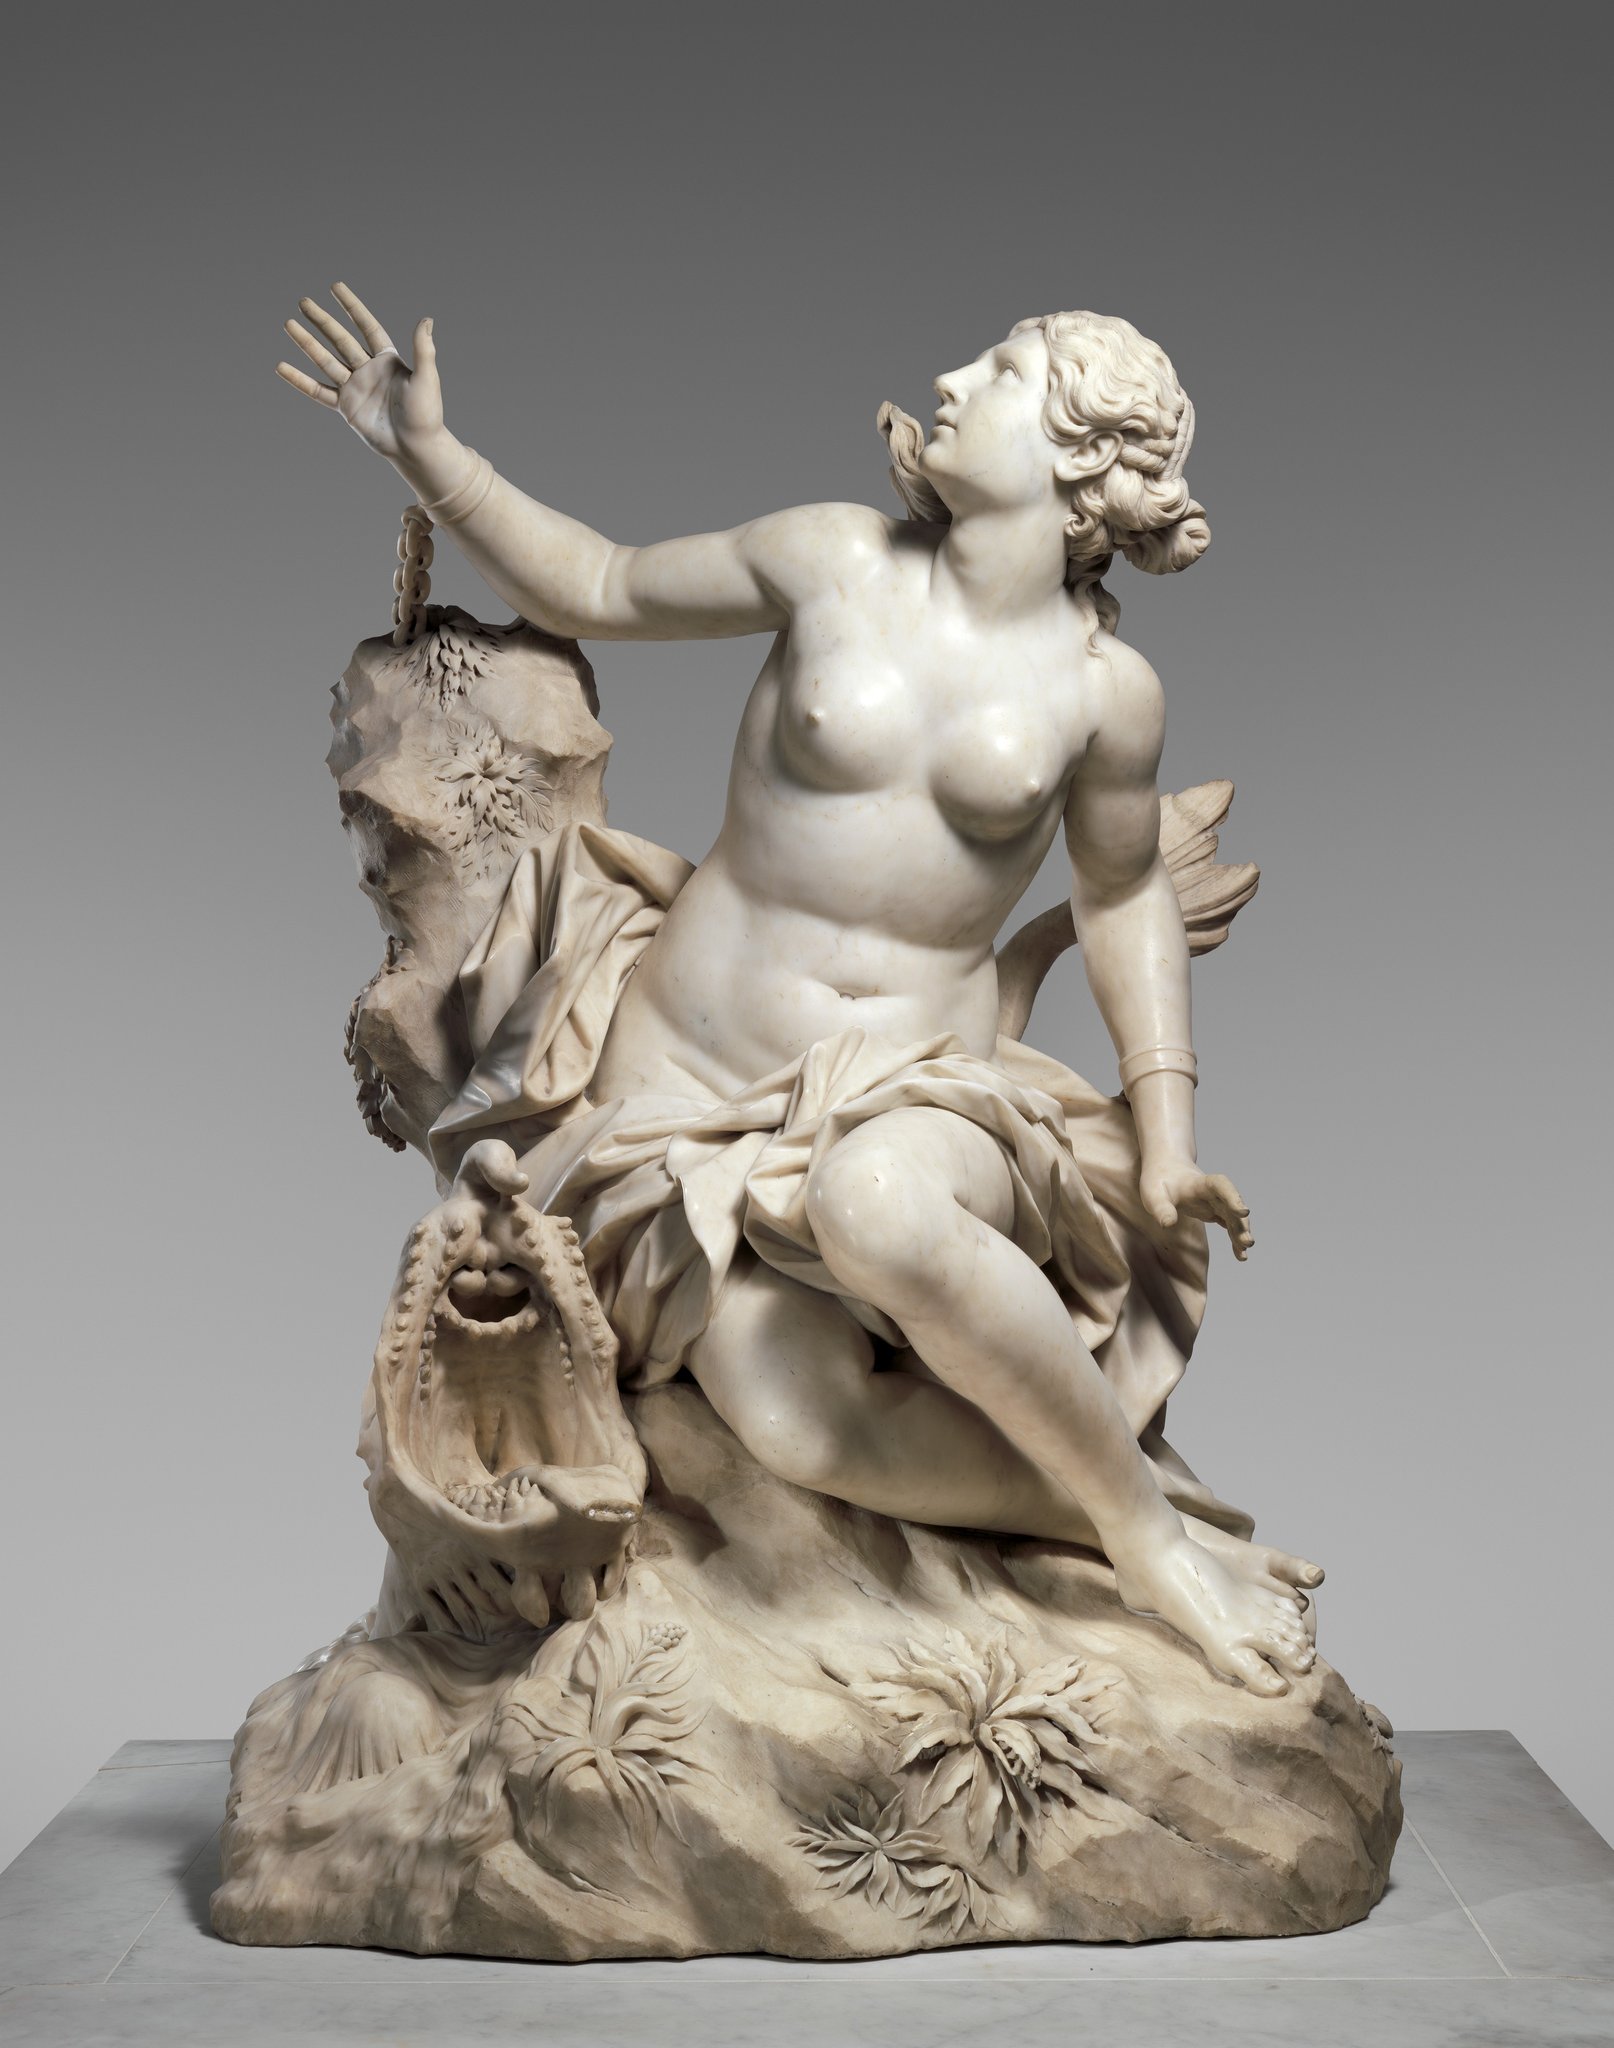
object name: group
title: Andromeda and the Sea Monster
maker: domenico guidi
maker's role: artist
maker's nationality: italian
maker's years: 1625-1701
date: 1694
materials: marble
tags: female nudes,andromeda,monsters